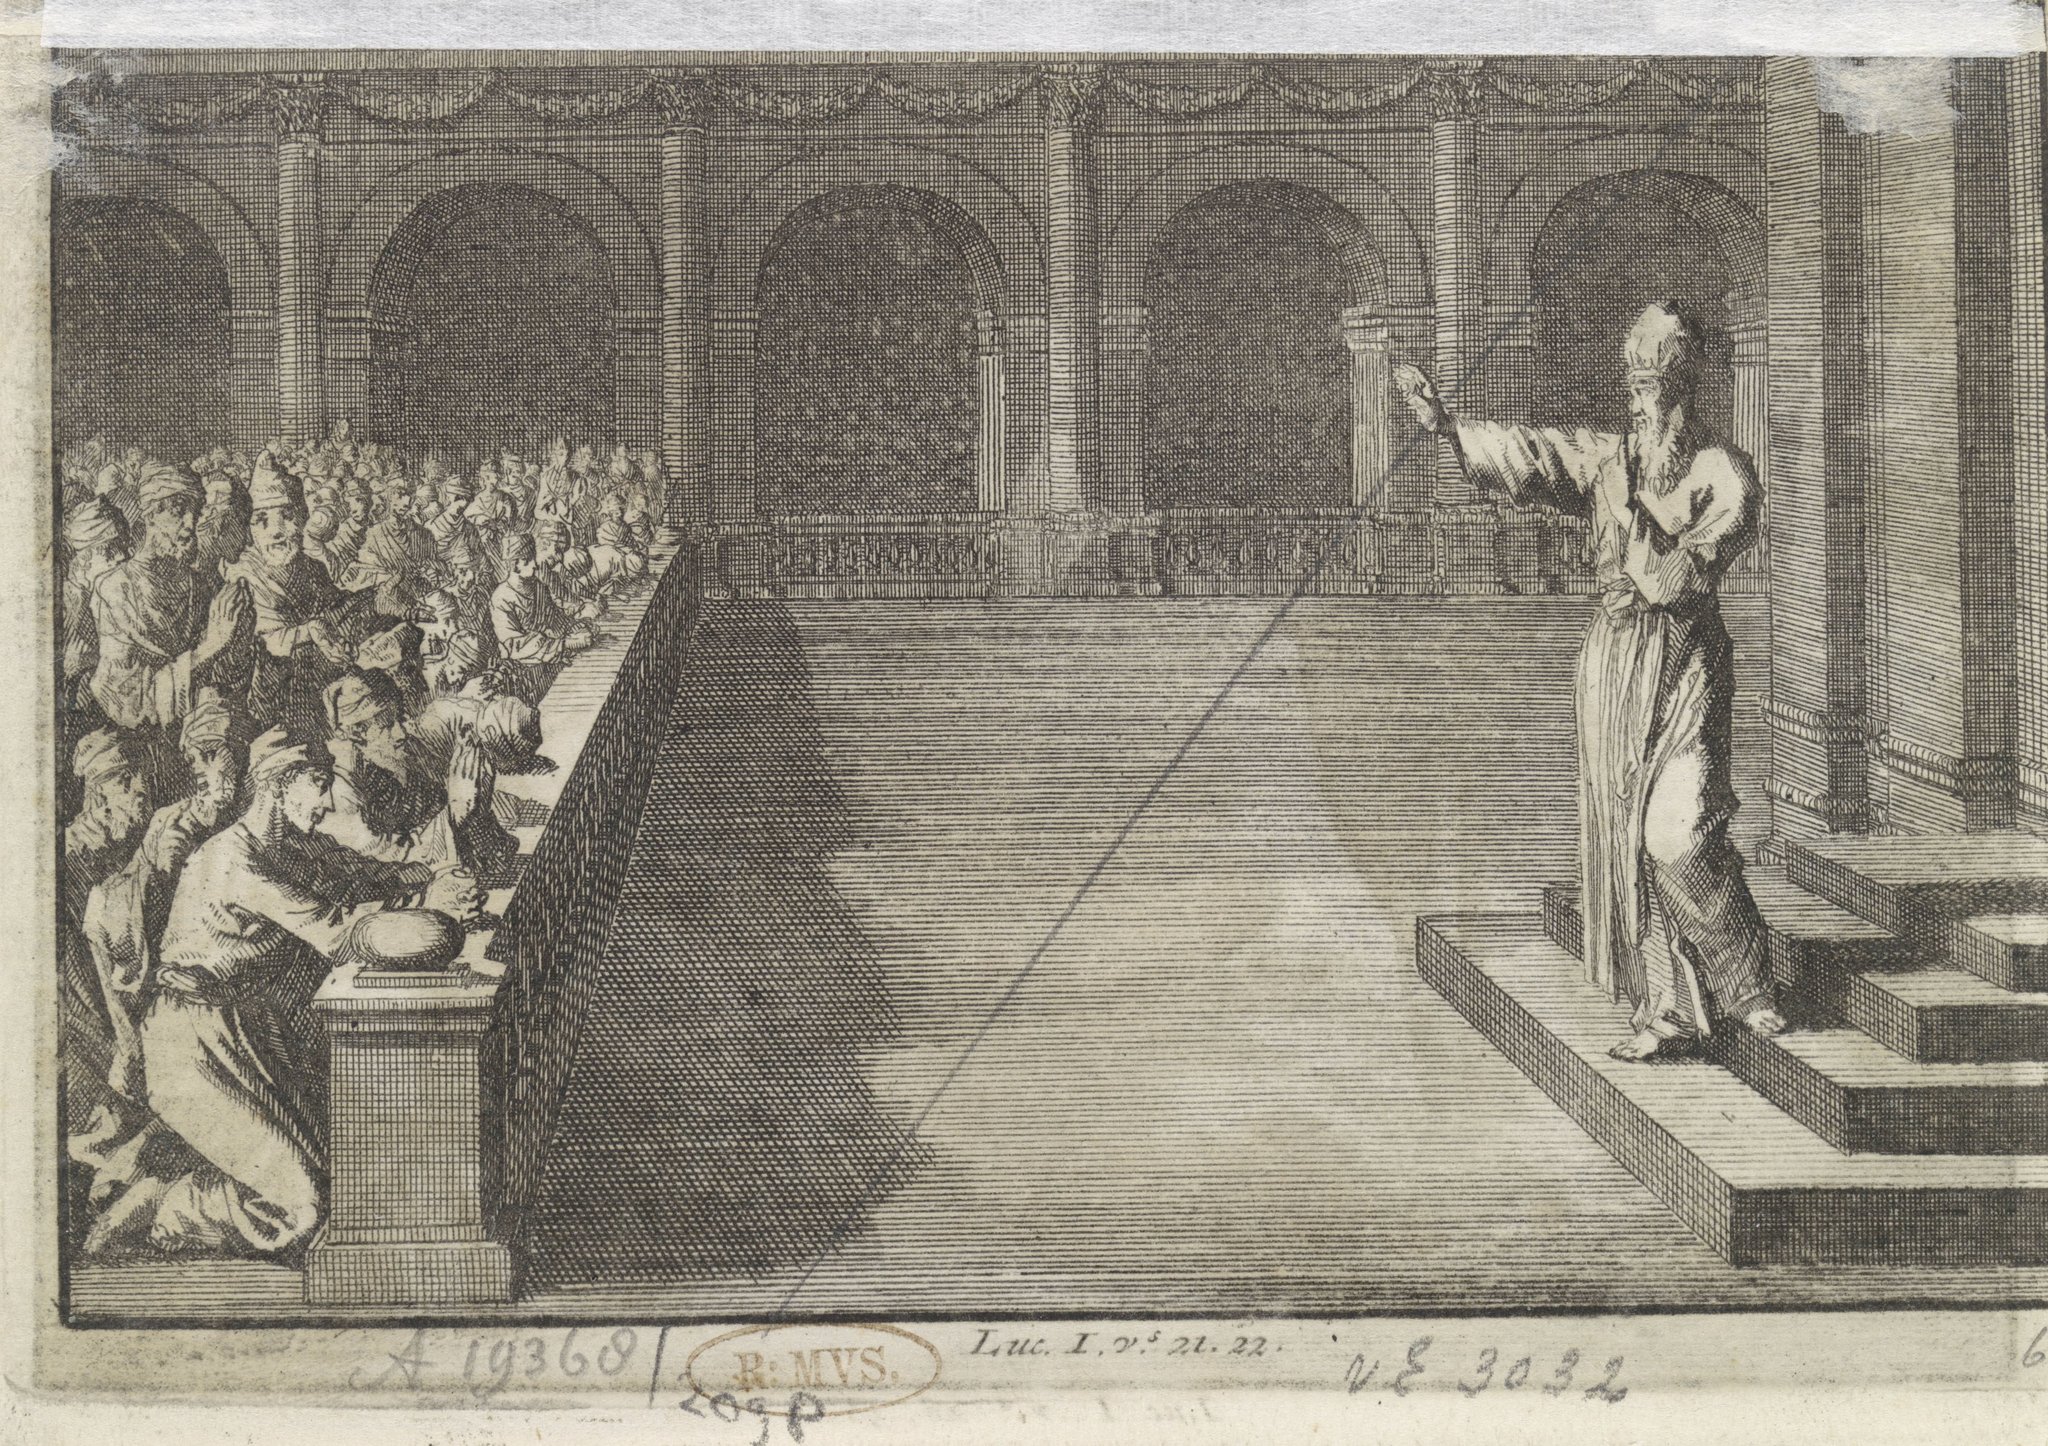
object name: print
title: Zacharias tracht de menigte toe te spreken maar blijft stom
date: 1703-1762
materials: paper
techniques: etching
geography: amsterdam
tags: zacharias speechless before the people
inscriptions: collector's mark: Lugt 2228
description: De prent komt een eerste keer voor als boekillustratie voor David Martin. Historie des Ouden en Nieuwen Testaments. Amsterdam, Pieter Mortier, 1703. Deel II. De boekillustraties voor de Mortierbijbel hebben verschillende staten en kopieën, waarbij de chronologische volgorde moeilijk te achterhalen valt. Als boekillustraties werden ze bovendien herhaaldelijk opnieuw gebruikt voor andere boekwerken.